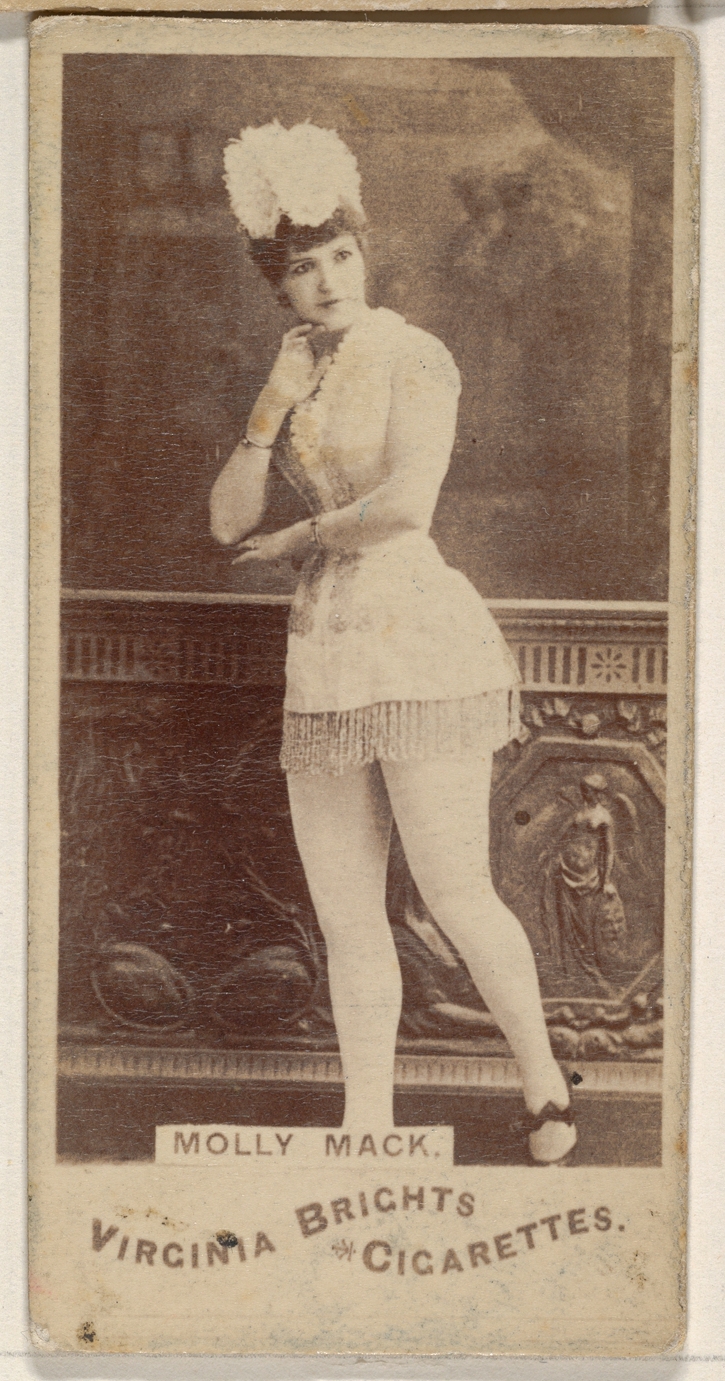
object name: photograph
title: Molly Mack, from the Actors and Actresses series (N45, Type 1) for Virginia Brights Cigarettes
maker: allen & ginter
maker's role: publisher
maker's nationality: american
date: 1888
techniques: albumen silver print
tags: portraits,women,actresses